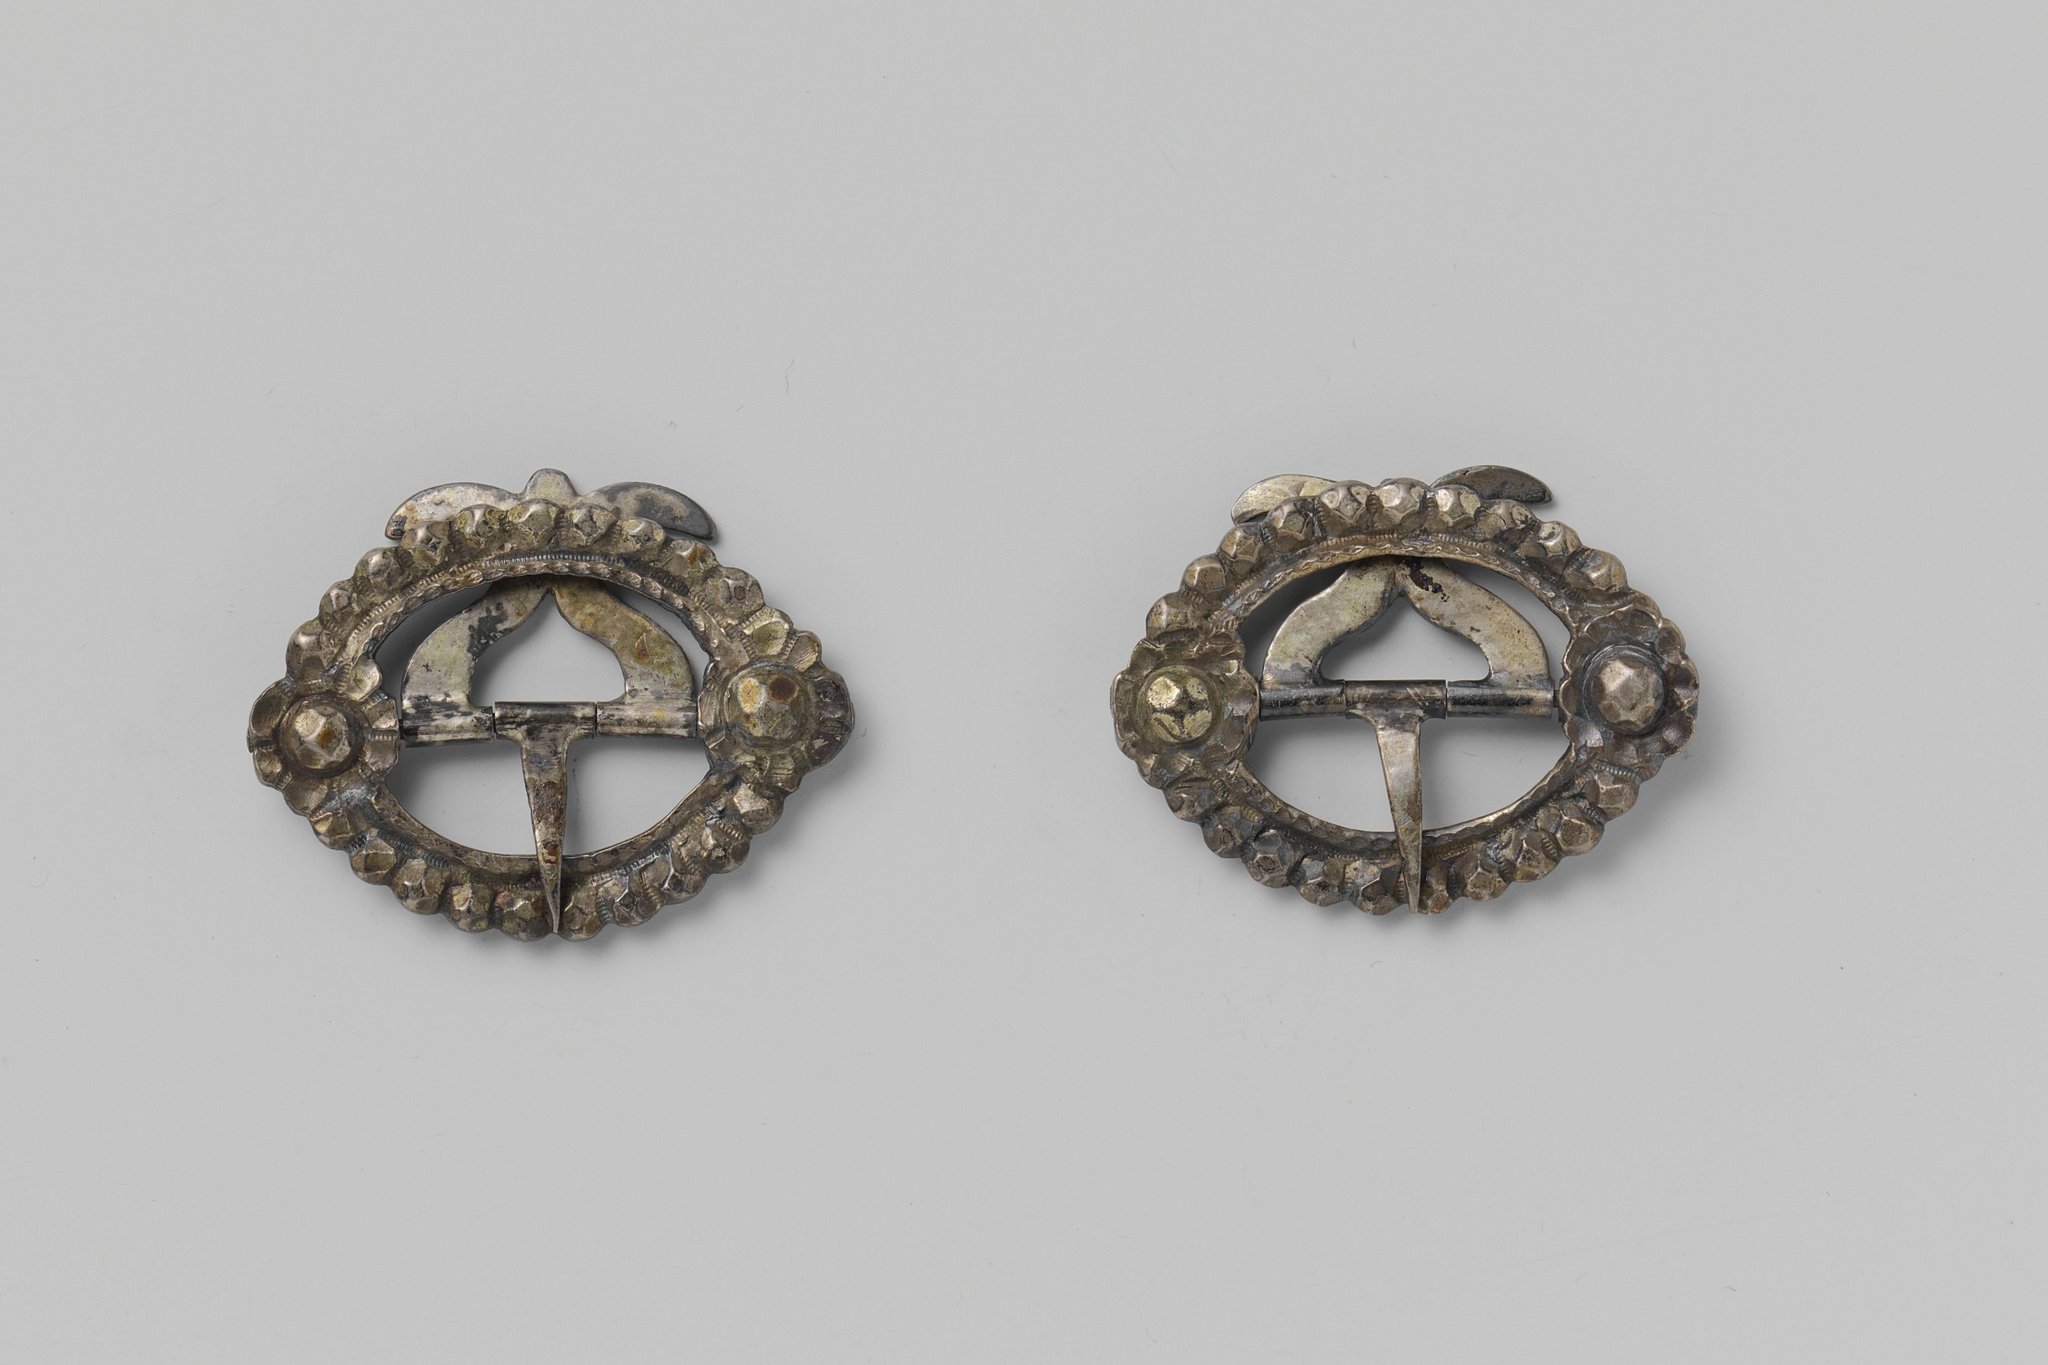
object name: buckle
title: Gesp van zilver, ovaalvormig met twee bloemen in reliëf in de hoeken van de vatting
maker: Anonymous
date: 1775-1800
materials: silk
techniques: forging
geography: france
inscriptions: silver mark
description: Gesp van zilver, ovaalvormig met twee bloemen in reliëf in de hoeken, overige vatting diamantvormig geslepen. Scharnierende sluiting aan de achterzijde, in de vorm van een visstaart.